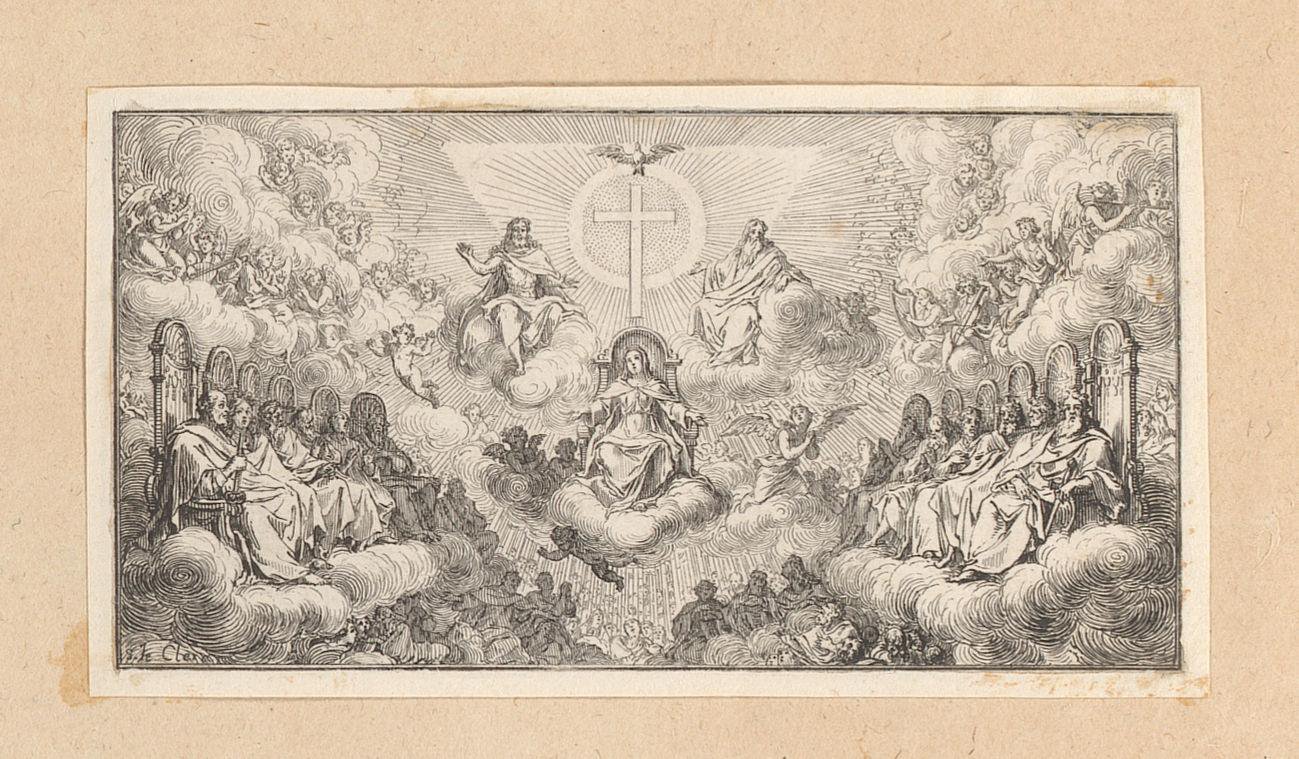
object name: album leaf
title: Heilige Drie-eenheid met de twaalf apostelen en engelen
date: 1696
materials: paper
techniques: etching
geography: paris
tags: the holy trinity, 'trinitas coelestis'; father, son and holy ghost ~ christian religion, the twelve apostles (as a group), usually with books or scrolls (not in biblical context)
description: Vignet uit: Fléchier, Esprit. Panegyriques et autres sermons (...). Parijs: Jean Anisson, 1696.